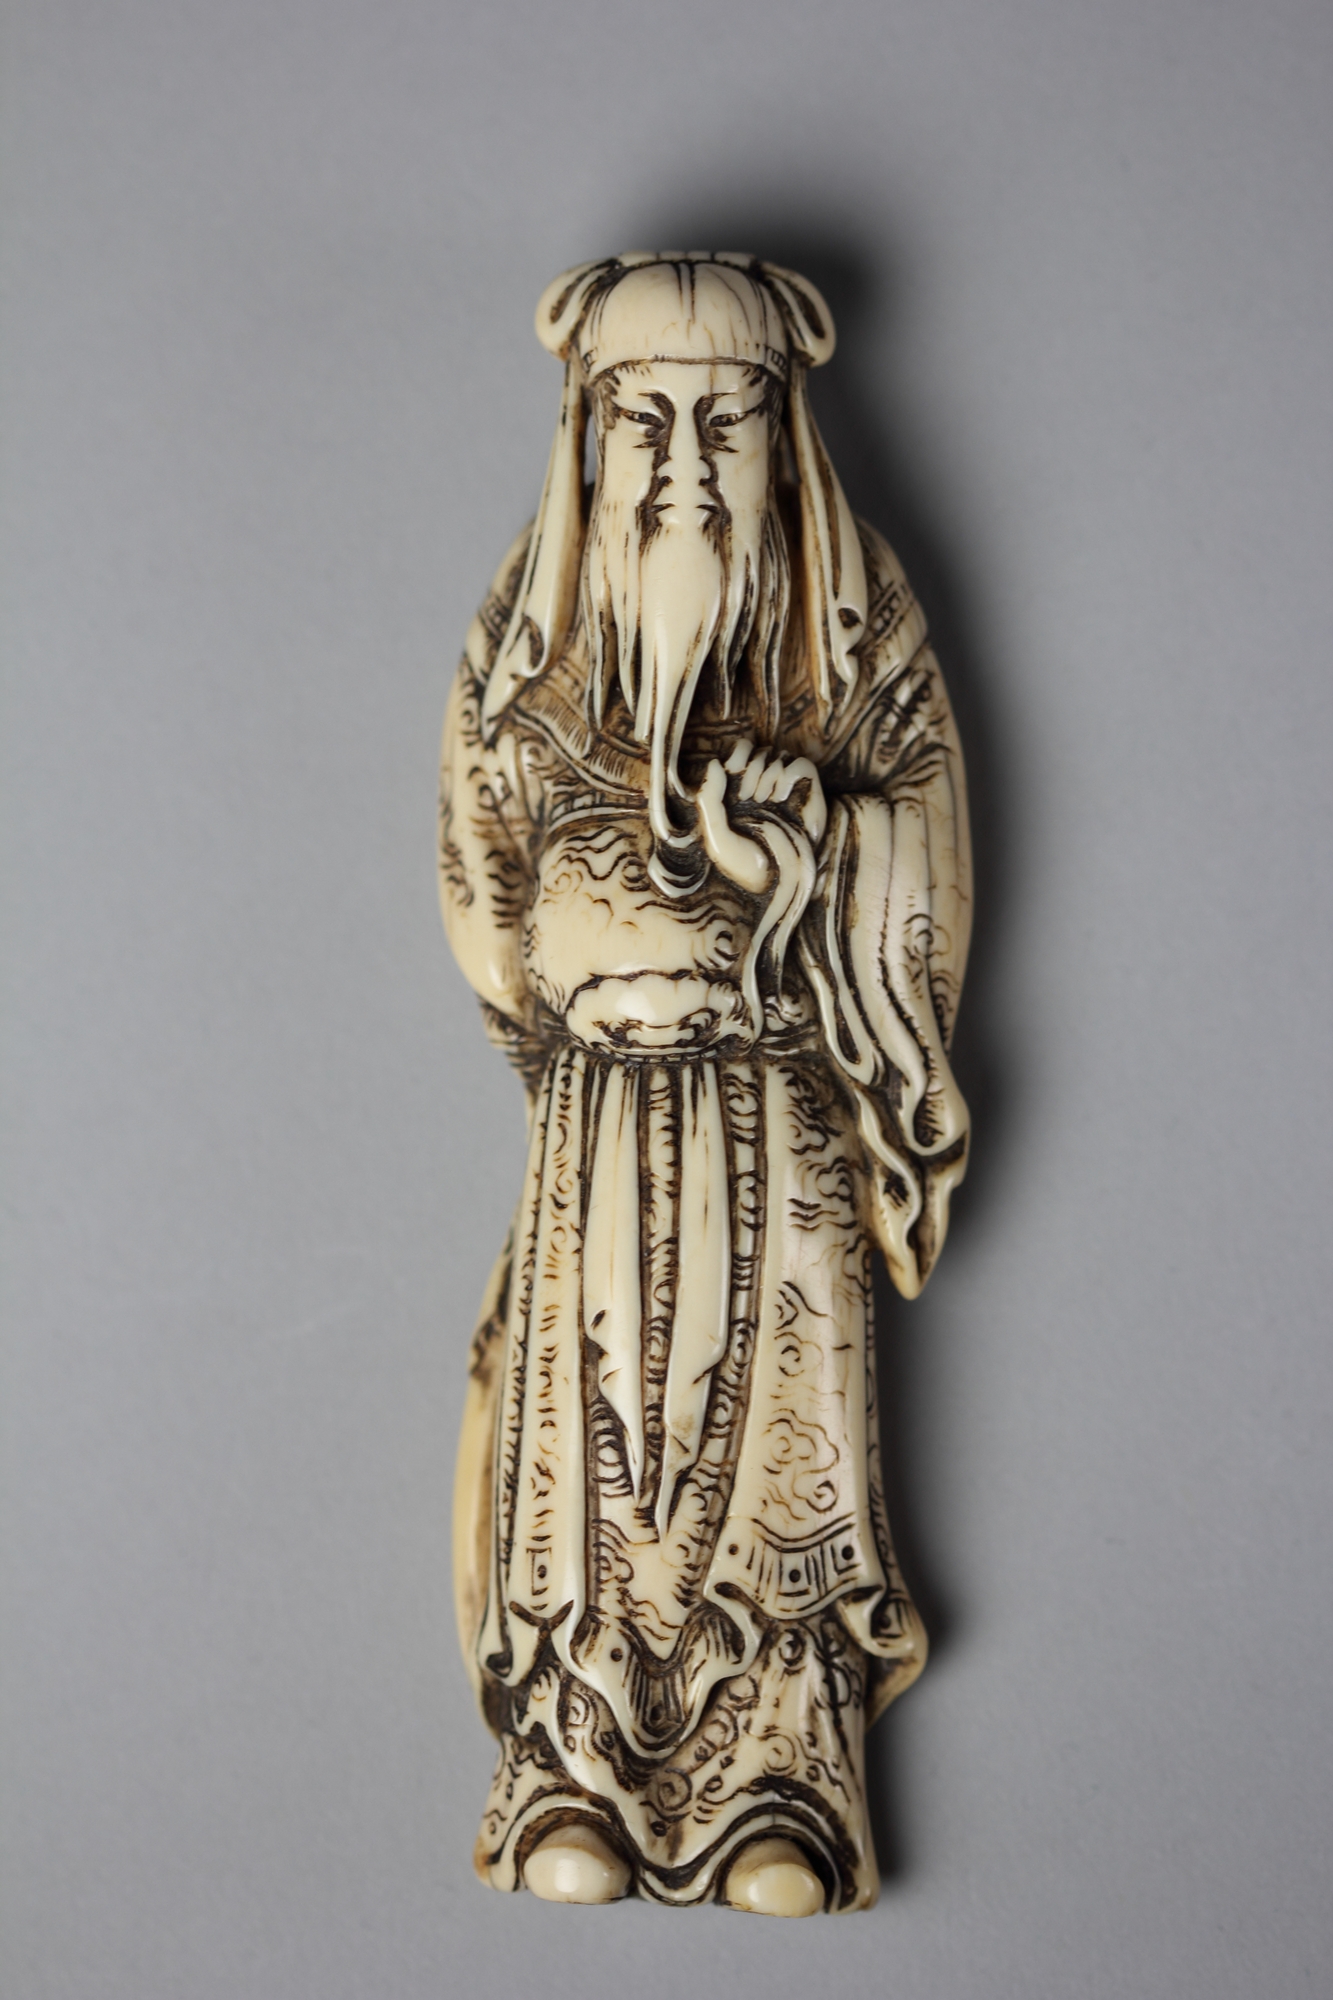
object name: netsuke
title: Chinese General Guan Yu (Kan’u)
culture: japanese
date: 1701-1800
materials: ivory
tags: fans,generals